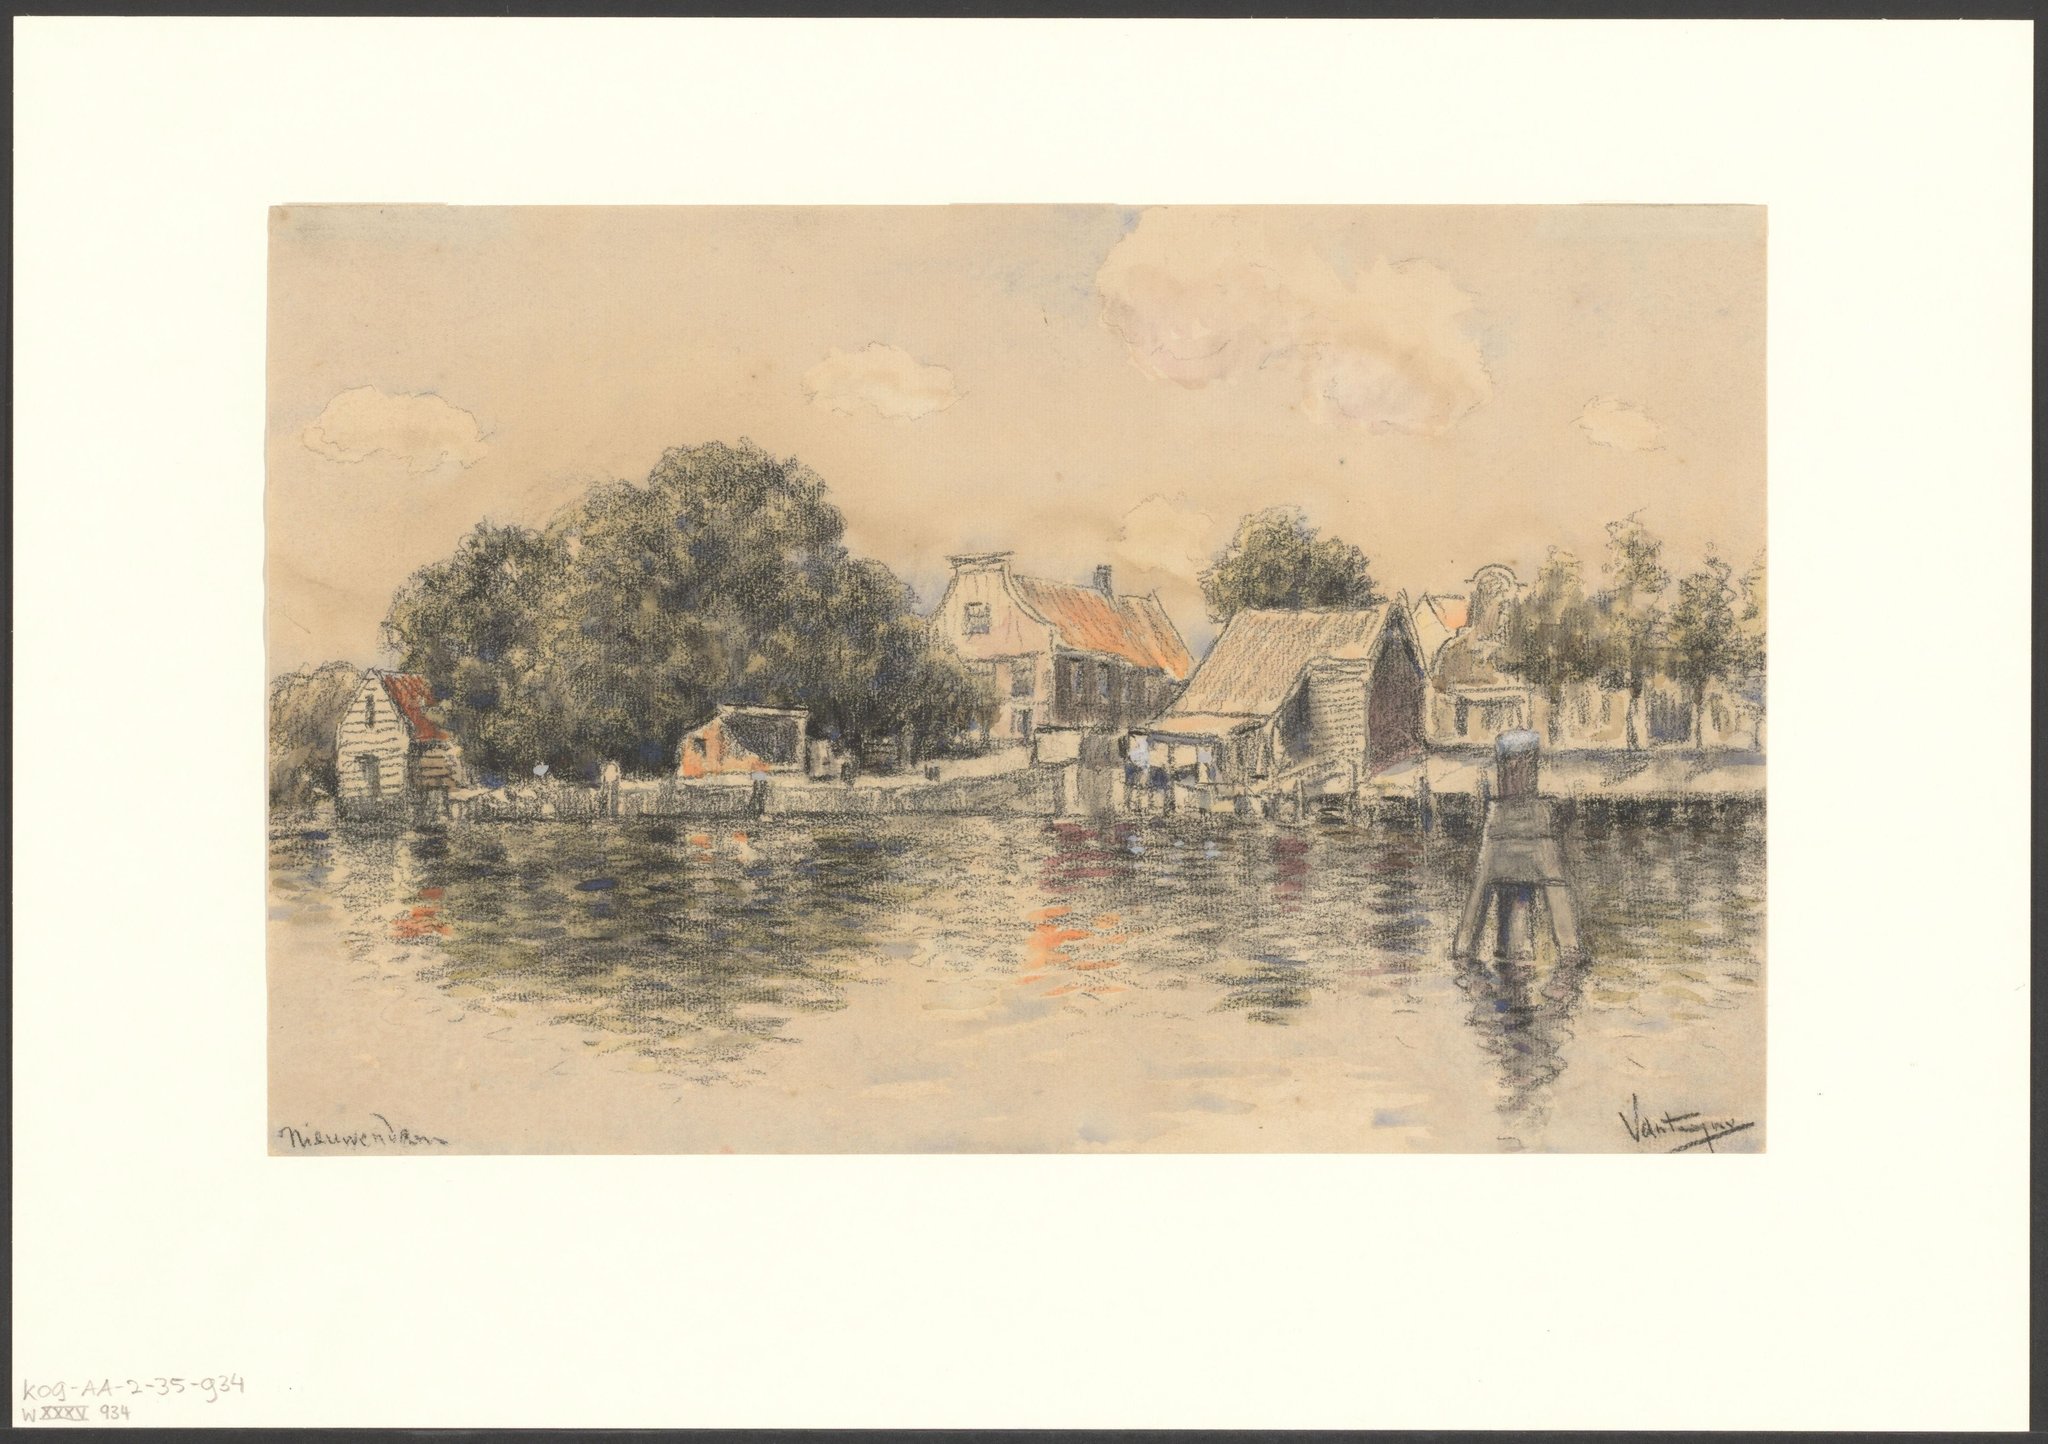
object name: drawing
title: Gezicht op de Grote Haven bij Nieuwendam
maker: anthonie van teijn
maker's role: draughtsman, painter, print maker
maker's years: 1863-1943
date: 1907-1928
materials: chalk, paper, watercolor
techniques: brush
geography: amsterdam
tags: harbour, village, the usual house or row of houses, street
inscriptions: collector's mark: Lugt 800a, signature: ‘VanTeyne’, inscription: ‘Gezicht vanaf het (...) Teyn Juli 1928’, inscription: ‘Nieuwendam’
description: Tekening binnen de Atlas Van Eck ingedeeld op wijknummer 35.